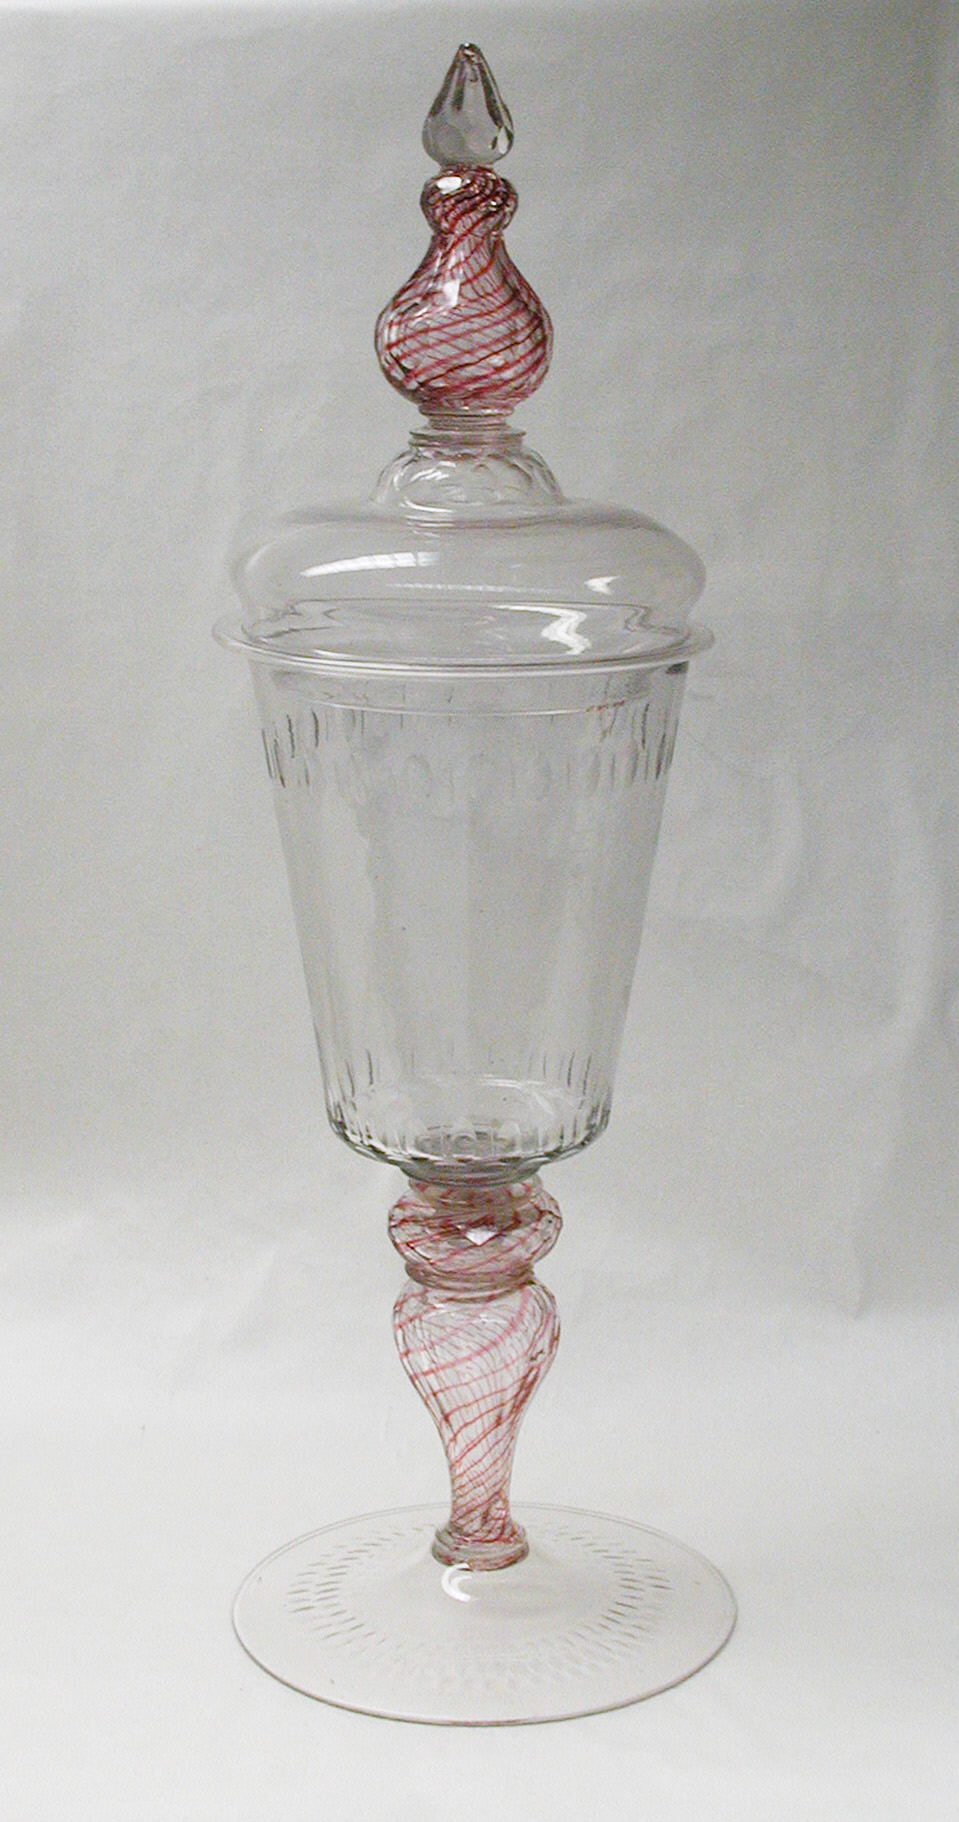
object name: standing cup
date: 1830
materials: glass